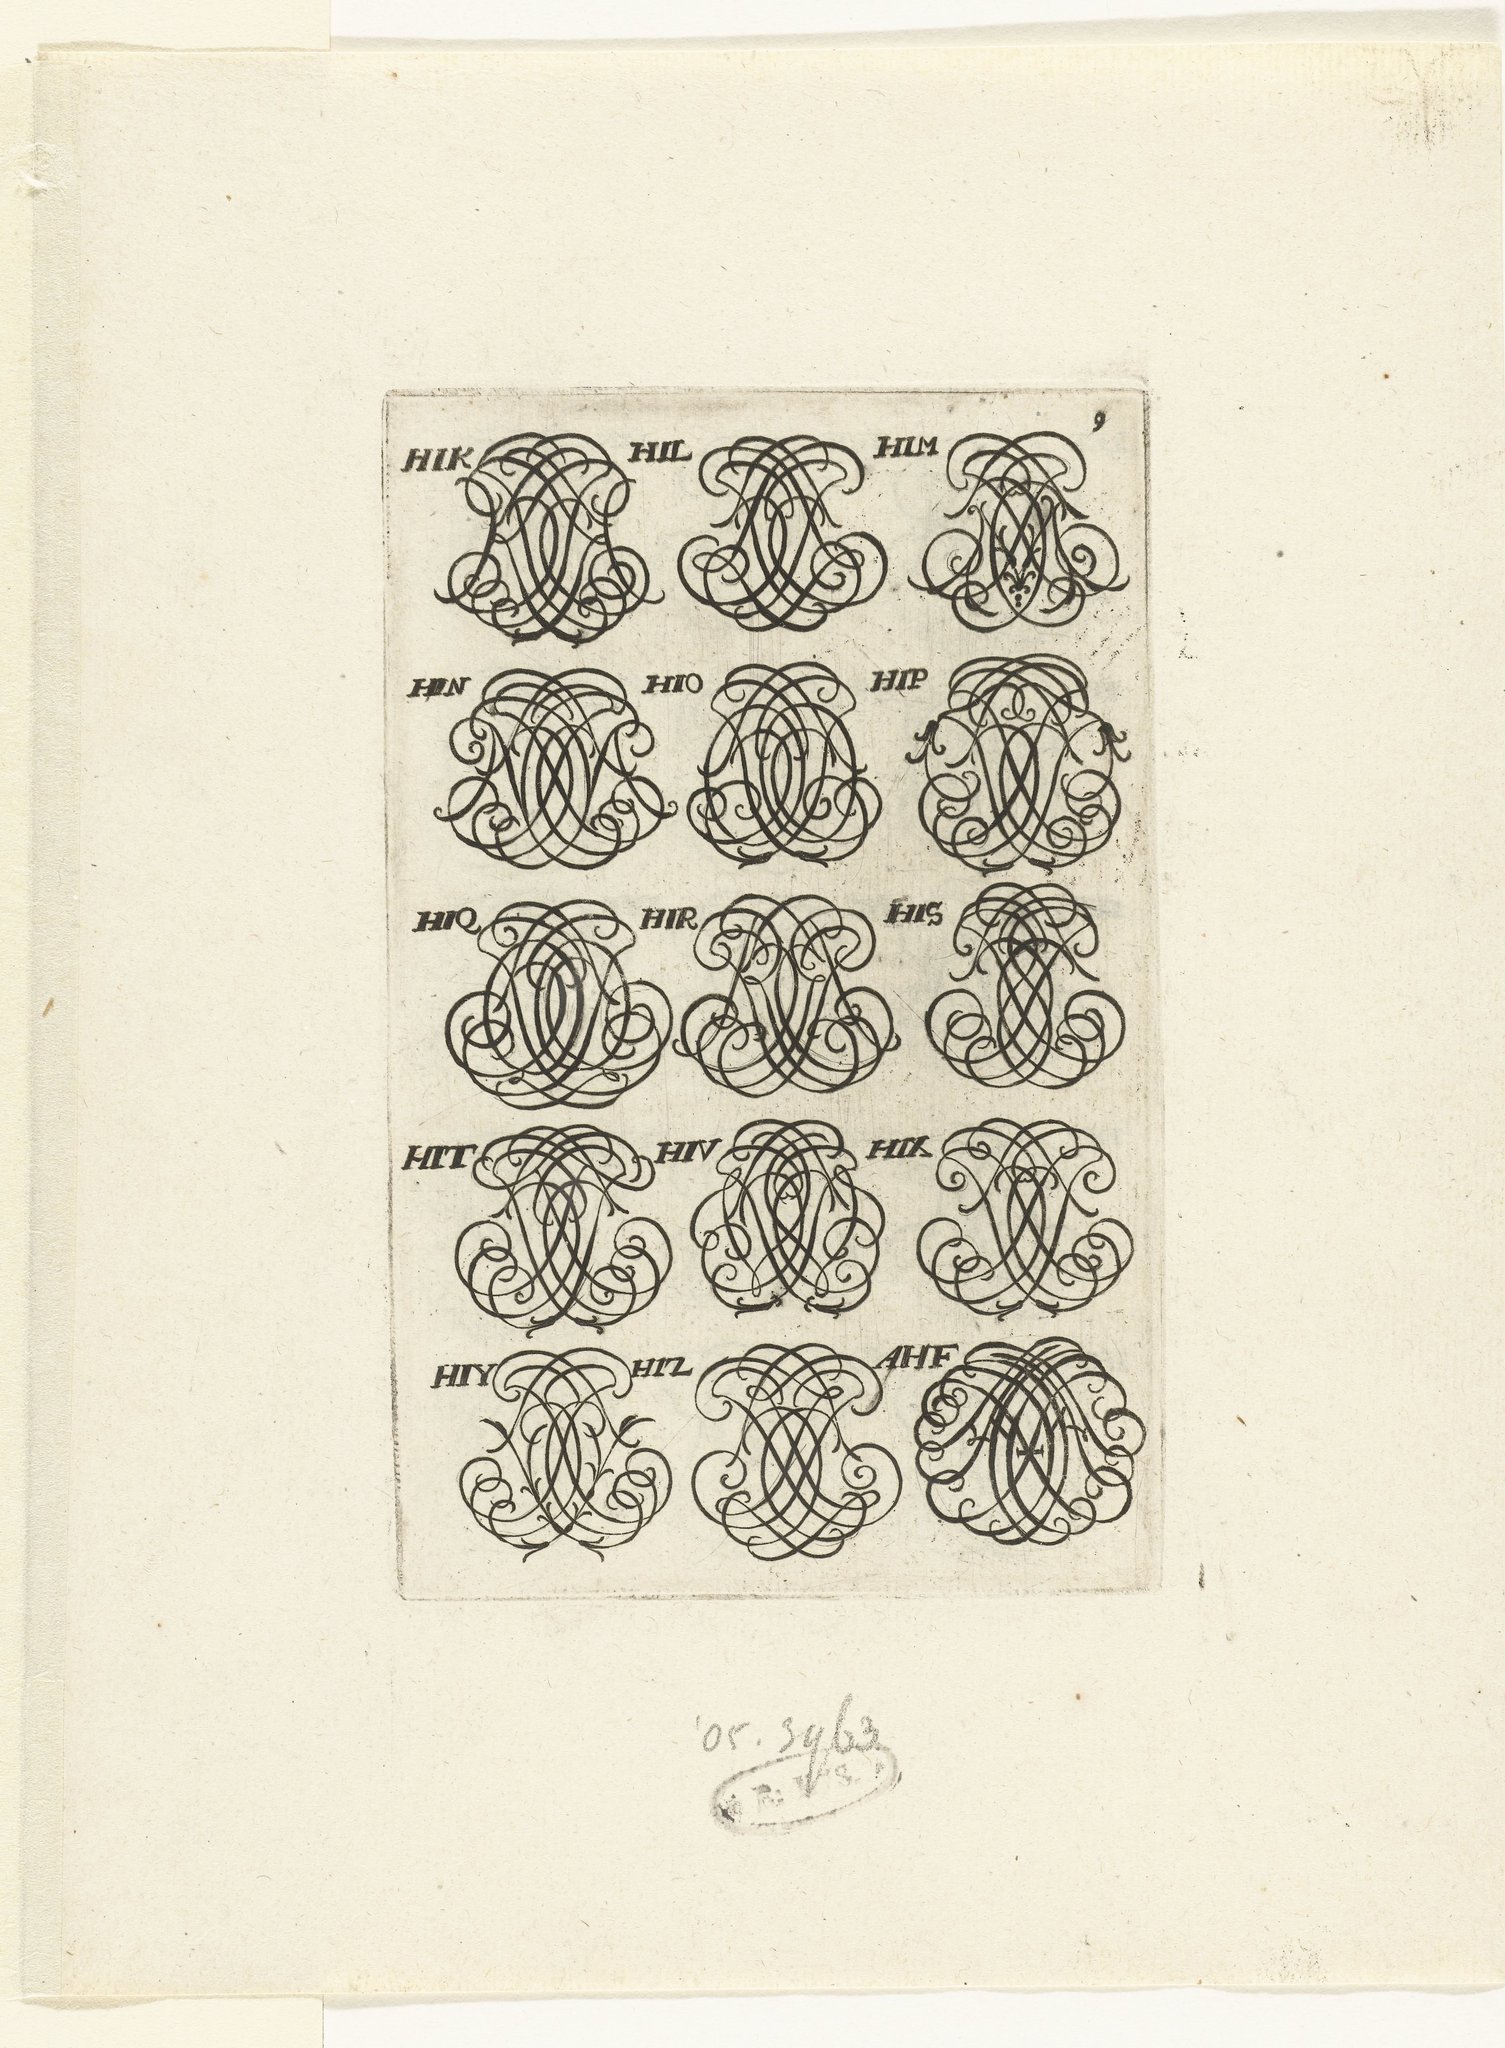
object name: ornament print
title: Vijftien lettermonogrammen (HIK-AHF)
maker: daniel de lafeuille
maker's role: print maker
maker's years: 1640-1709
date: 1690-1691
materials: paper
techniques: engraving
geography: amsterdam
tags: letters, alphabet, script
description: Uit serie van 29 deels genummerde bladen met cijfermonogrammen.